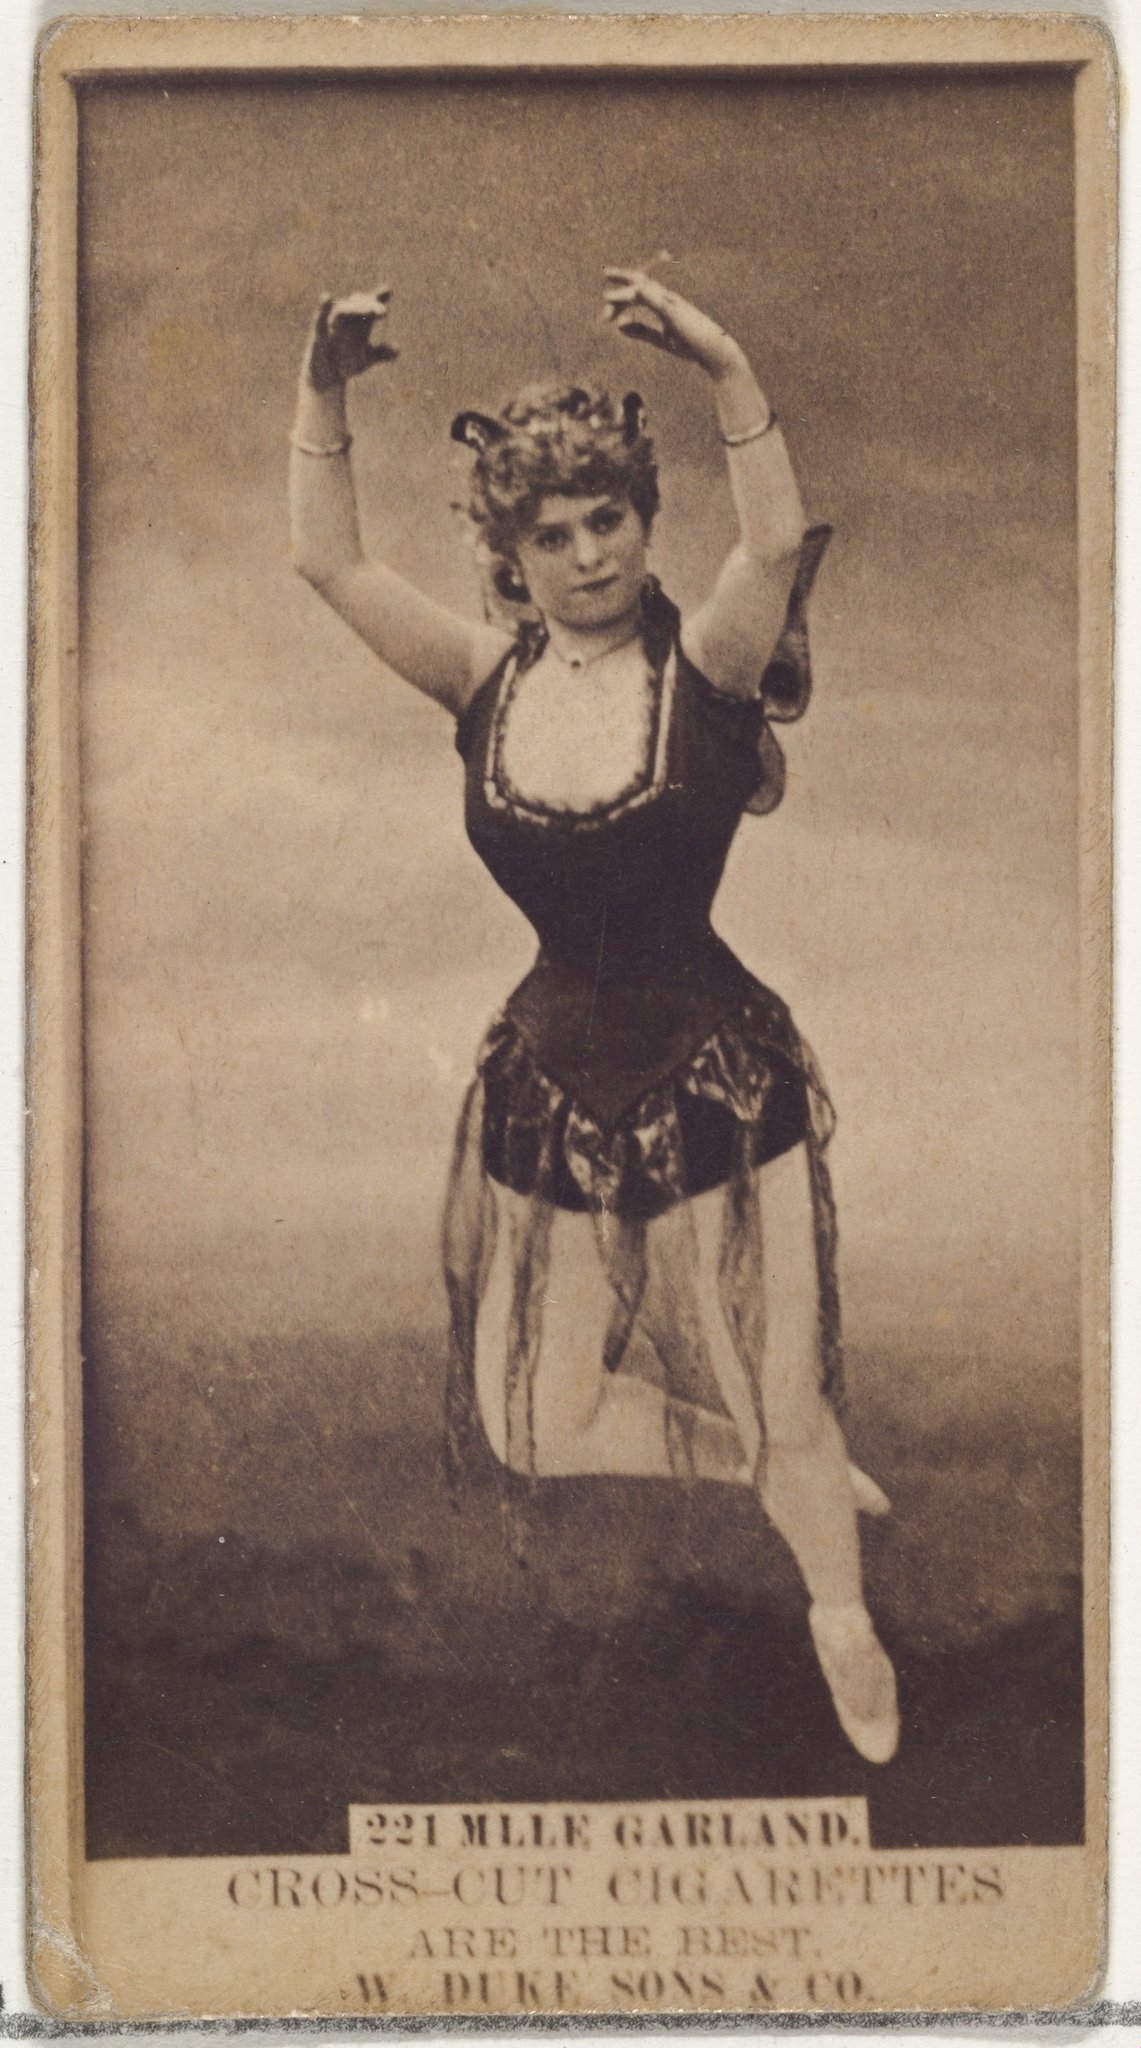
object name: photograph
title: Card Number 221, Mlle. Garland, from the Actors and Actresses series (N145-3) issued by Duke Sons & Co. to promote Cross Cut Cigarettes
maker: w. duke, sons & co.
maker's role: publisher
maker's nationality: american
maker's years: 1870-1920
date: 1880-1889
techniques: albumen silver print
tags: portraits,women,actresses